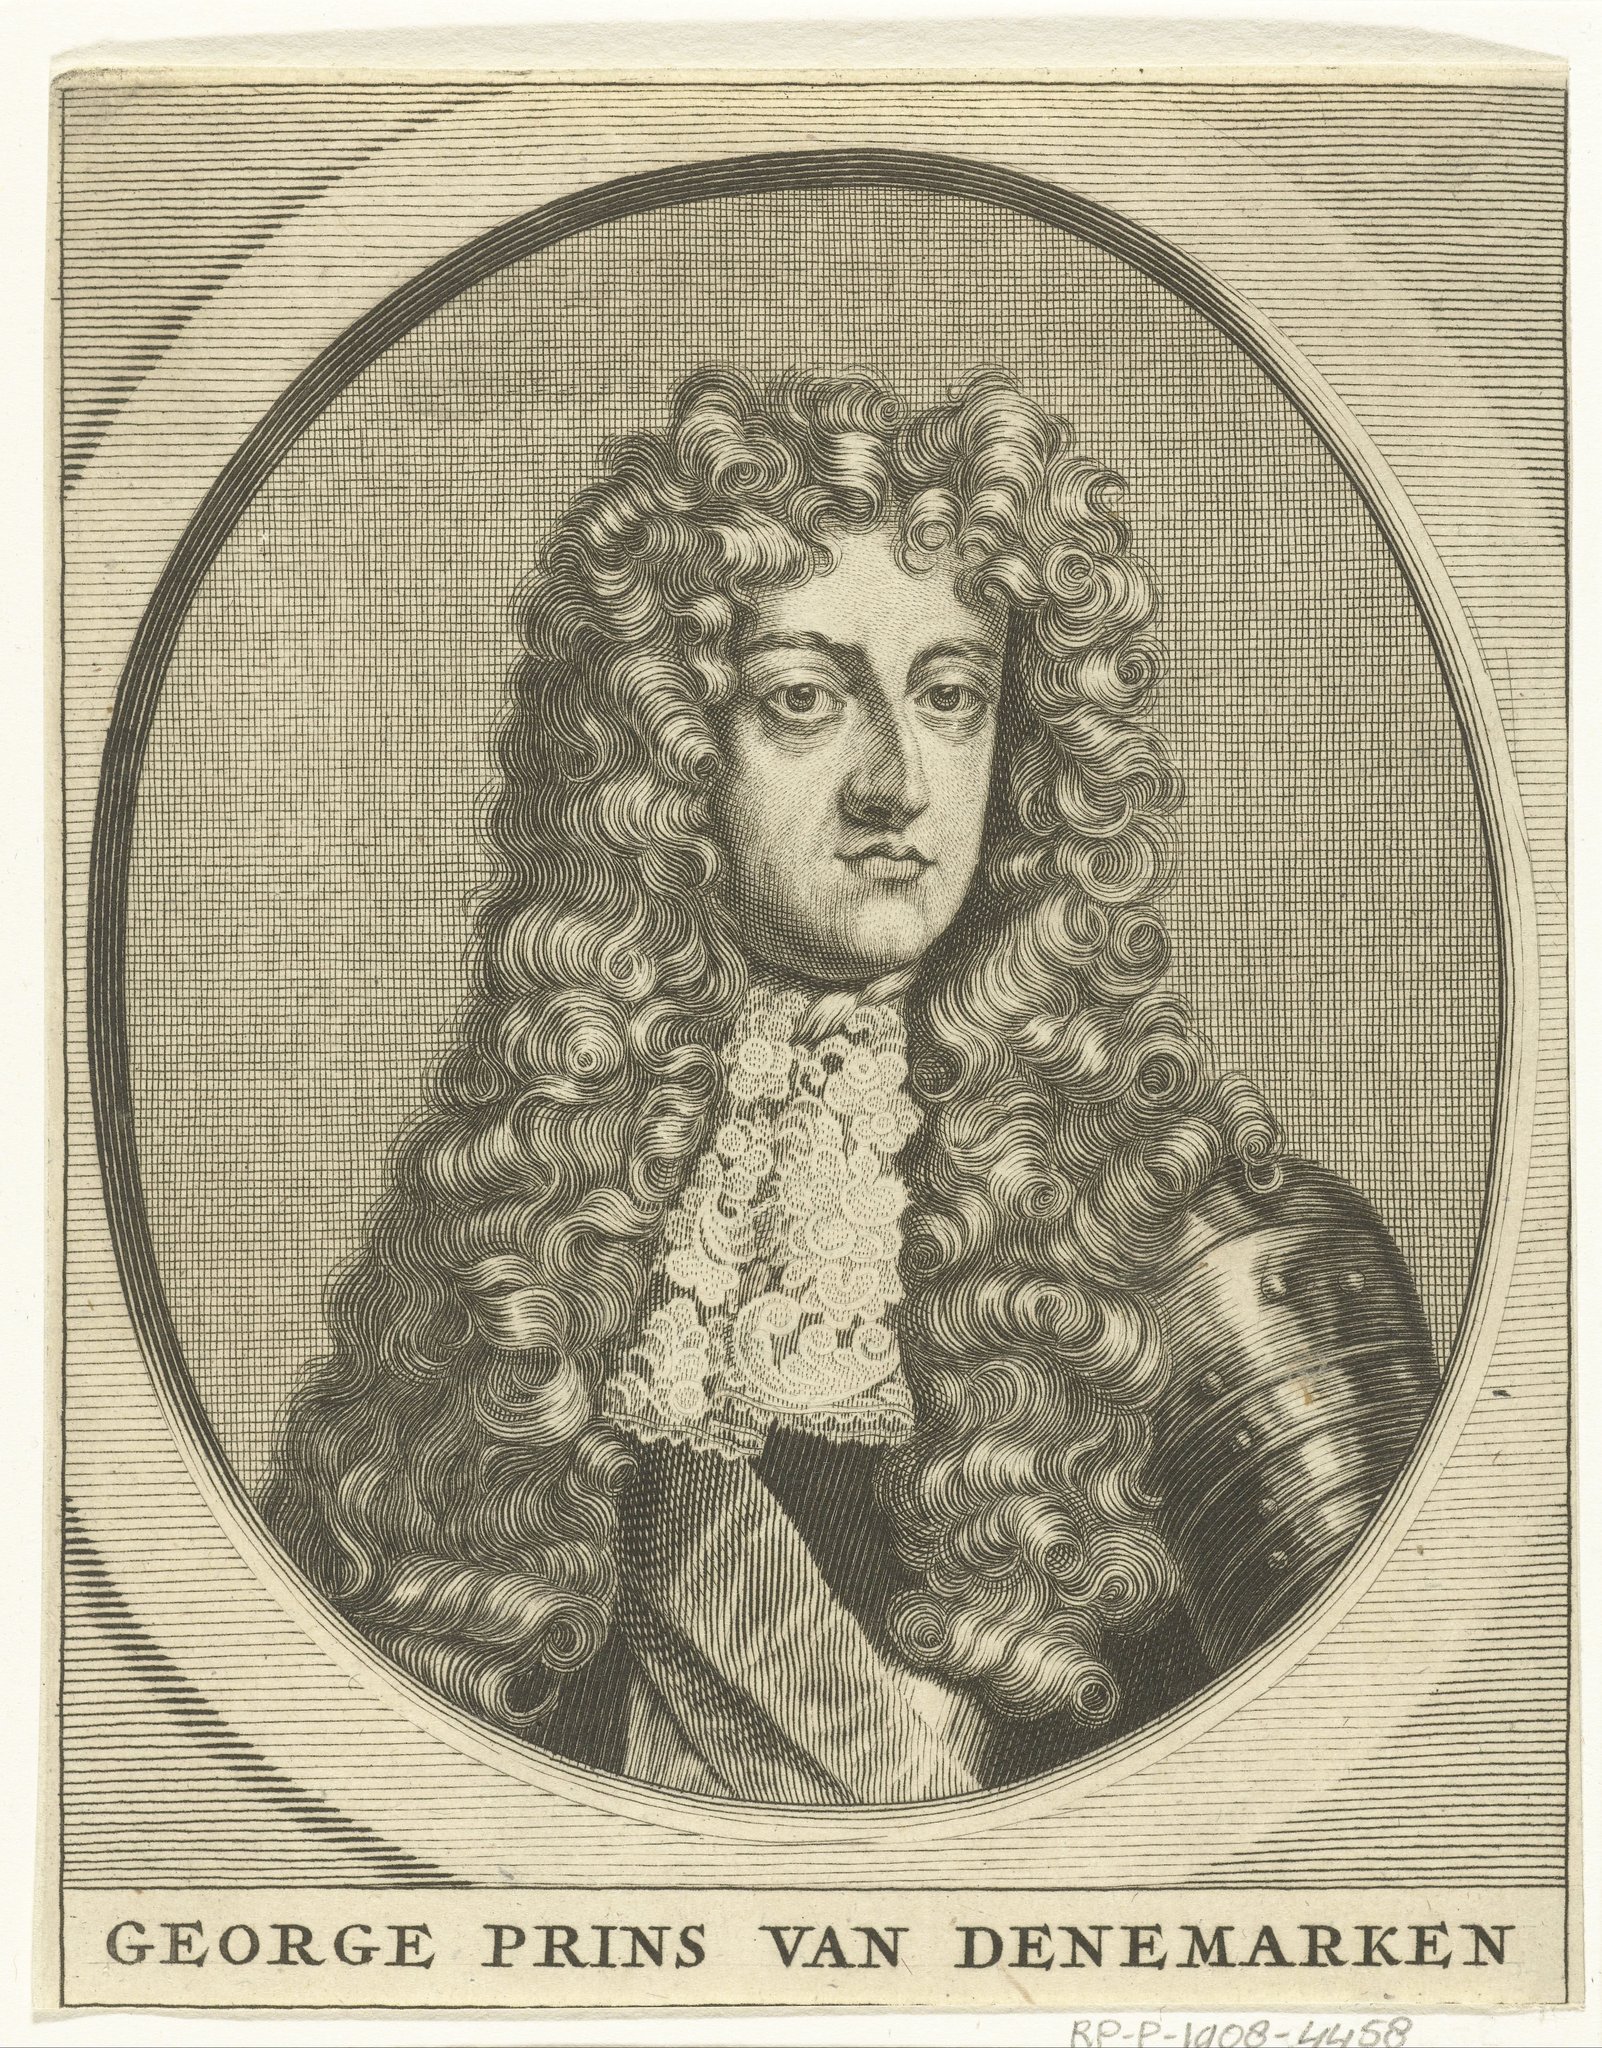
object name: print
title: George Prins van Denemarken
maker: françois van bleyswijck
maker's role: draughtsman, print maker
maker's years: 1671-1746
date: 1681-1746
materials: paper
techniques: engraving, etching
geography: leiden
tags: george (prins van denemarken)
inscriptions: collector's mark: Lugt 2228